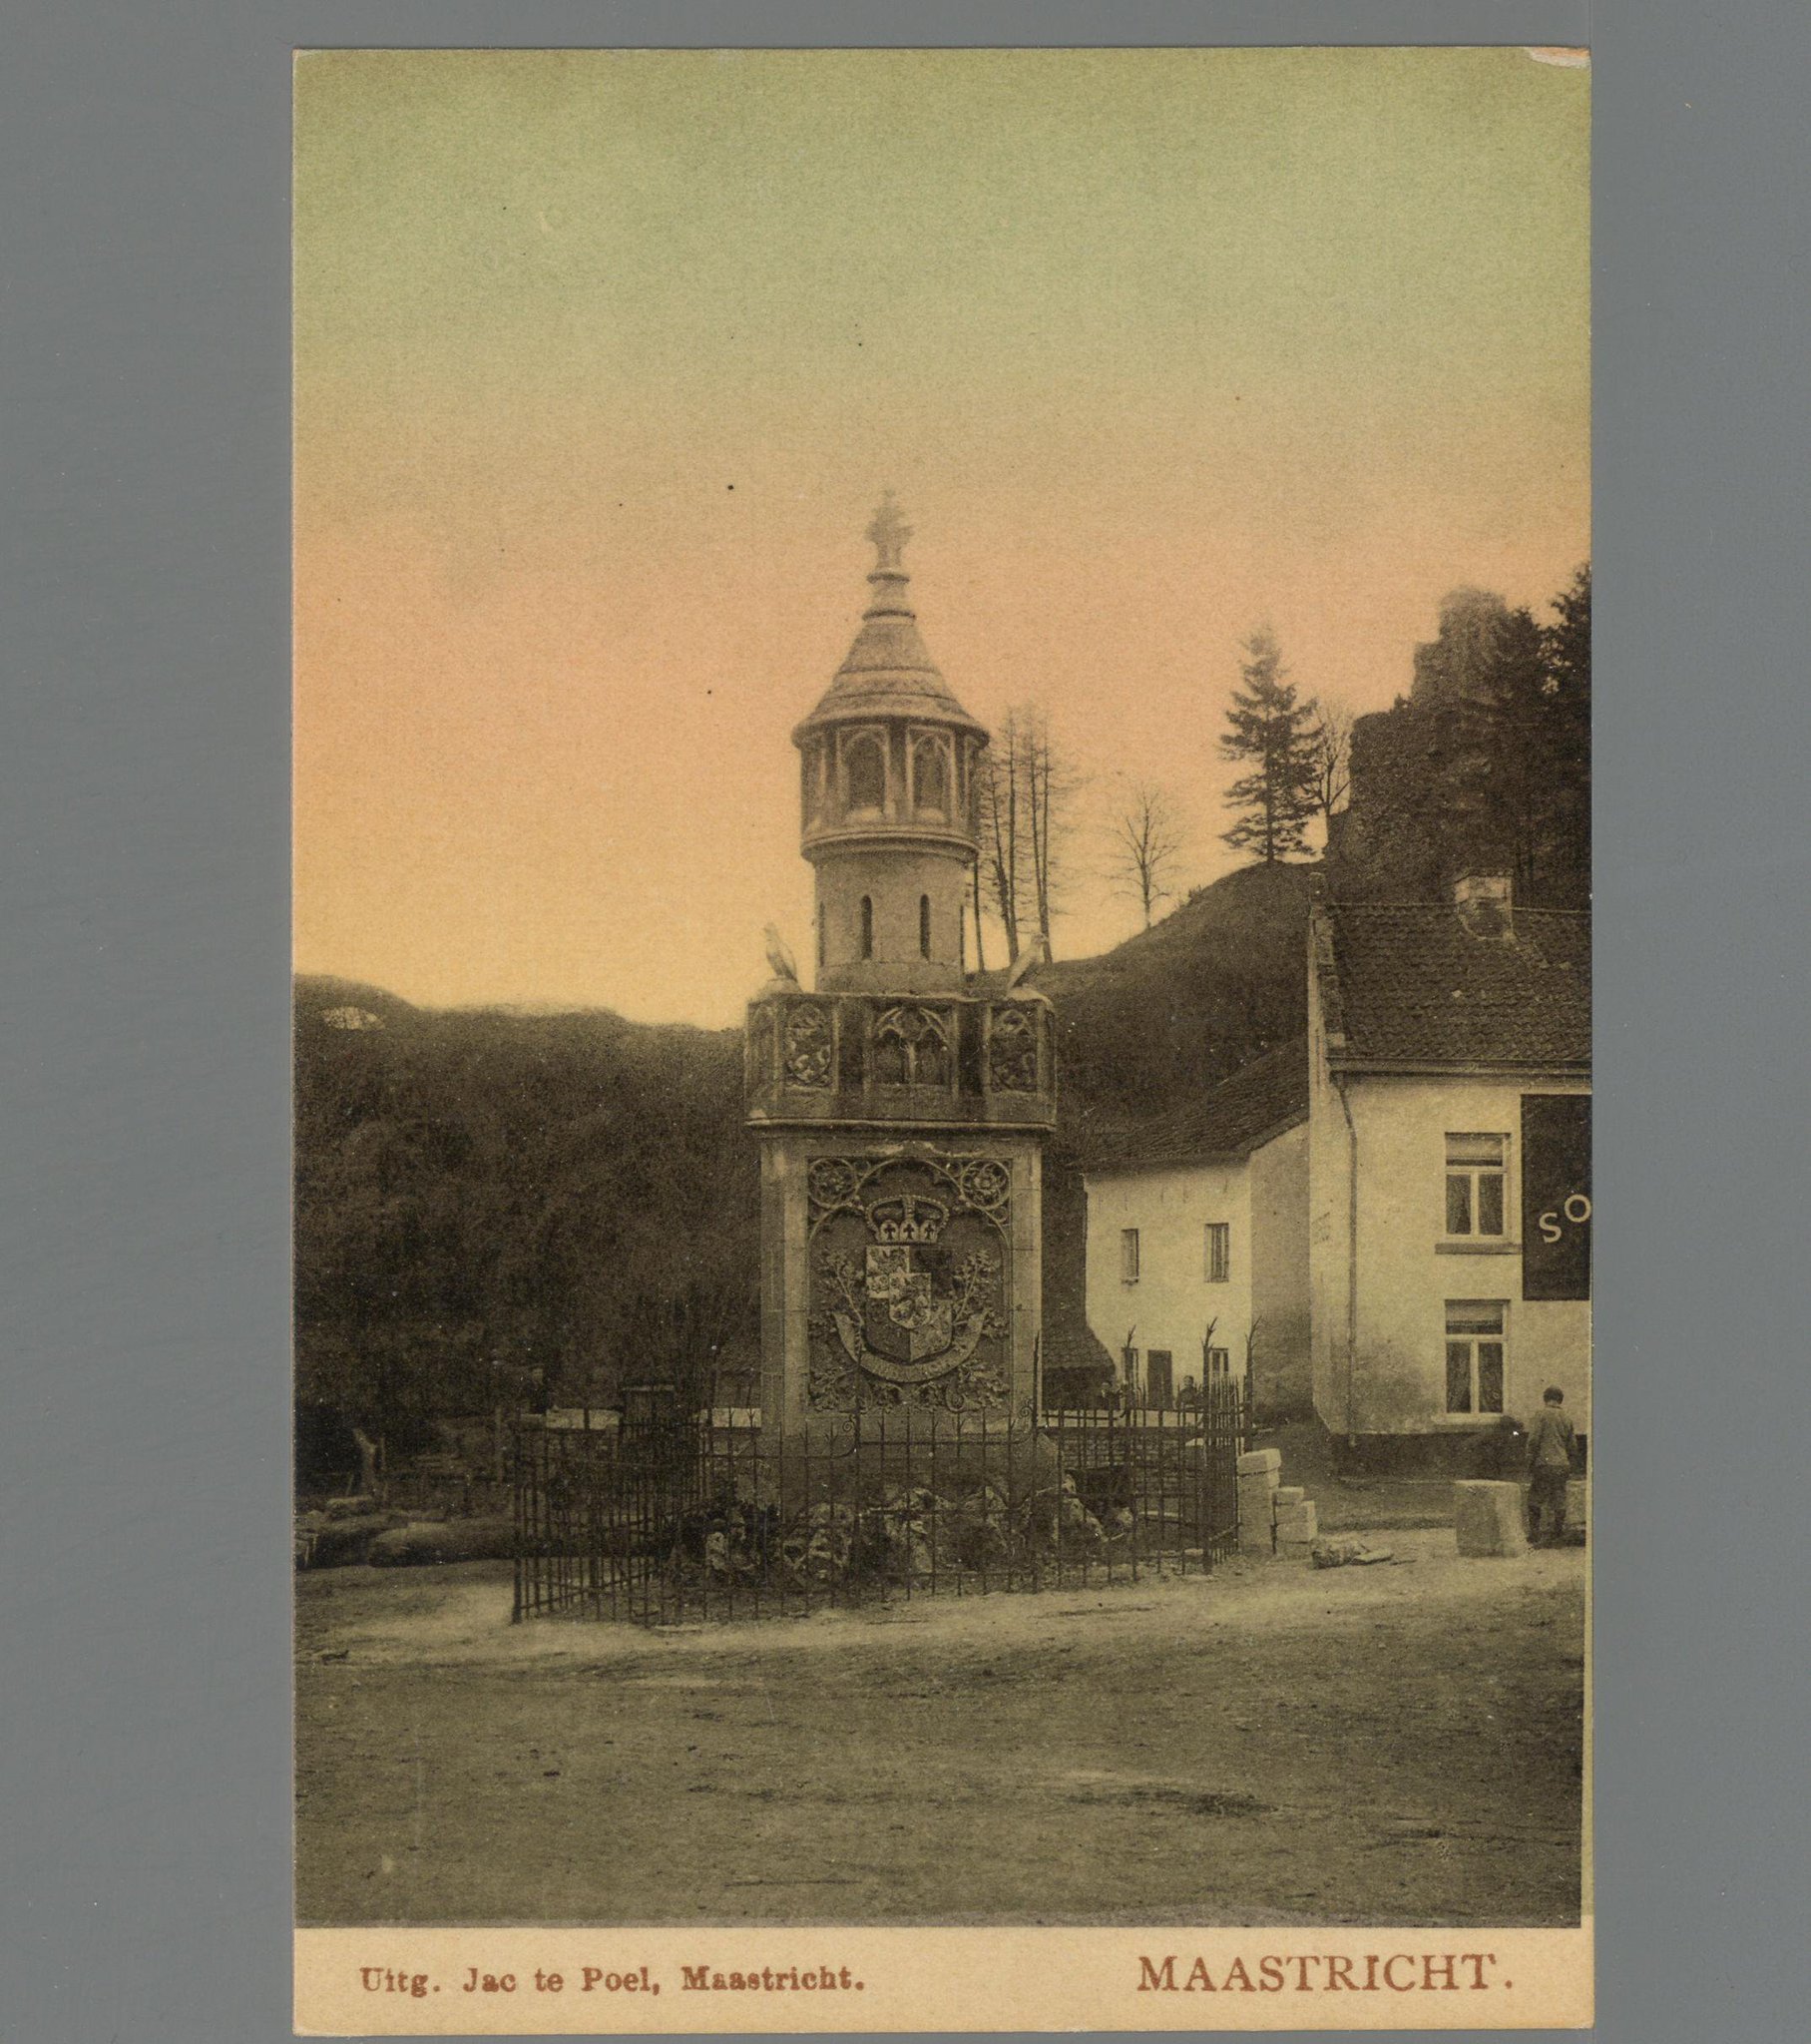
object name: ansichtkaart, prentbriefkaart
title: Maastricht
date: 1905-1919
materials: cardboard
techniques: photograph, iris print, lithograph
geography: maastricht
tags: monument, statue, maastricht